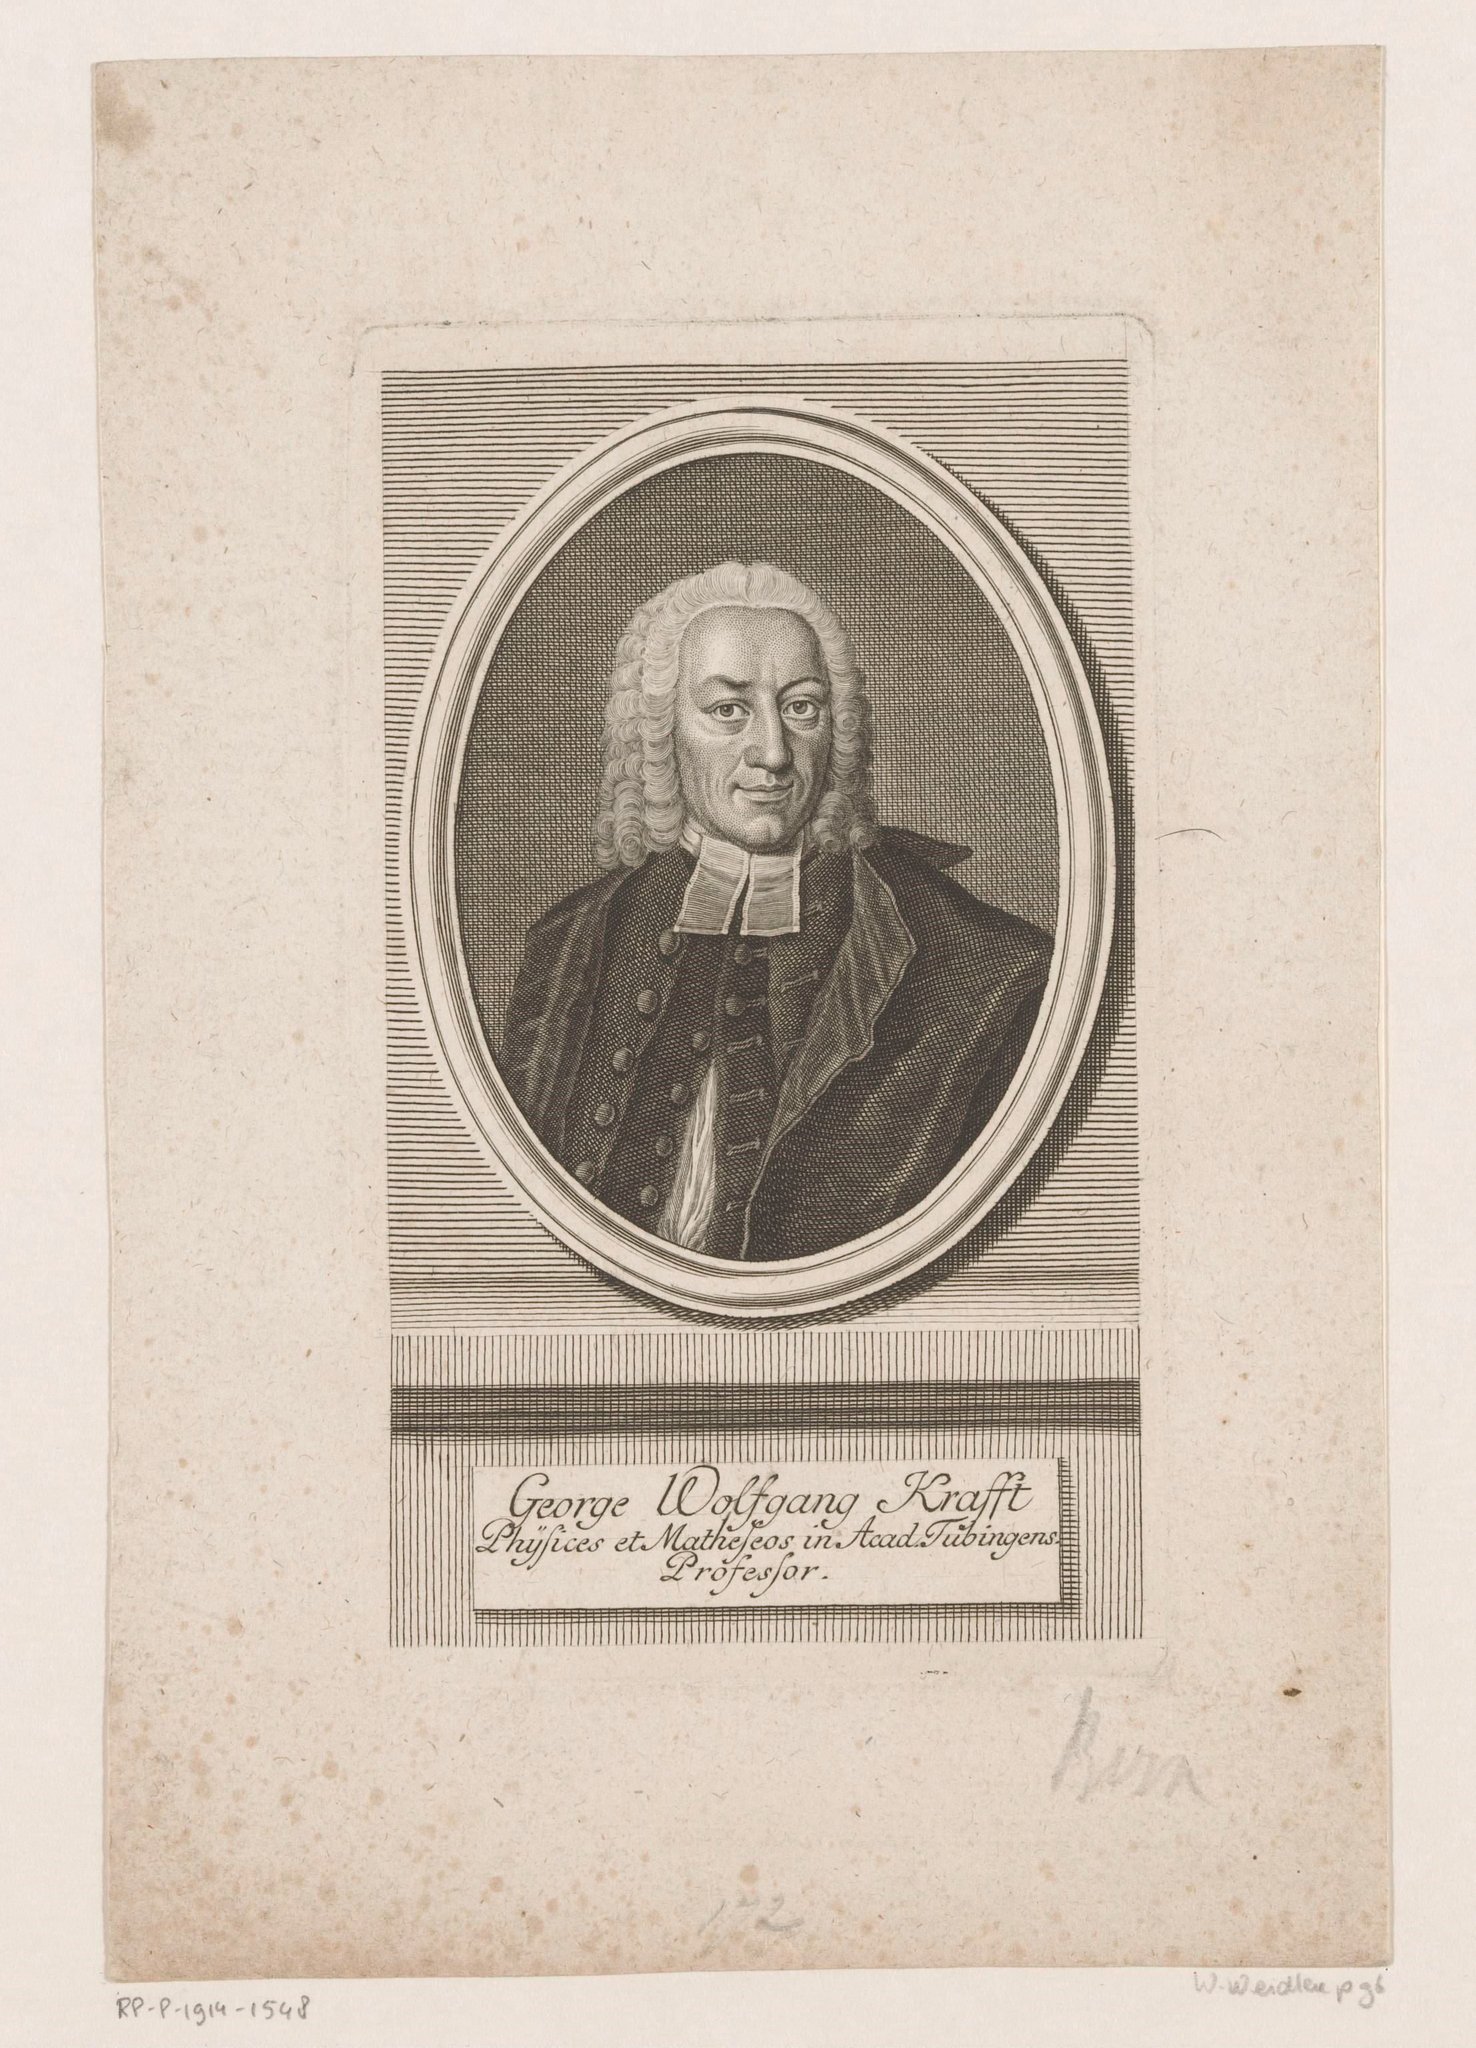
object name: print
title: Portret van Georg Wolfgang Krafft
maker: johann martin bernigeroth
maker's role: print maker, publisher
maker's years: 1713-1767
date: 1744-1767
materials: paper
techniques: engraving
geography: leipzig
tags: physicist, historical persons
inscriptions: collector's mark: Lugt 2228